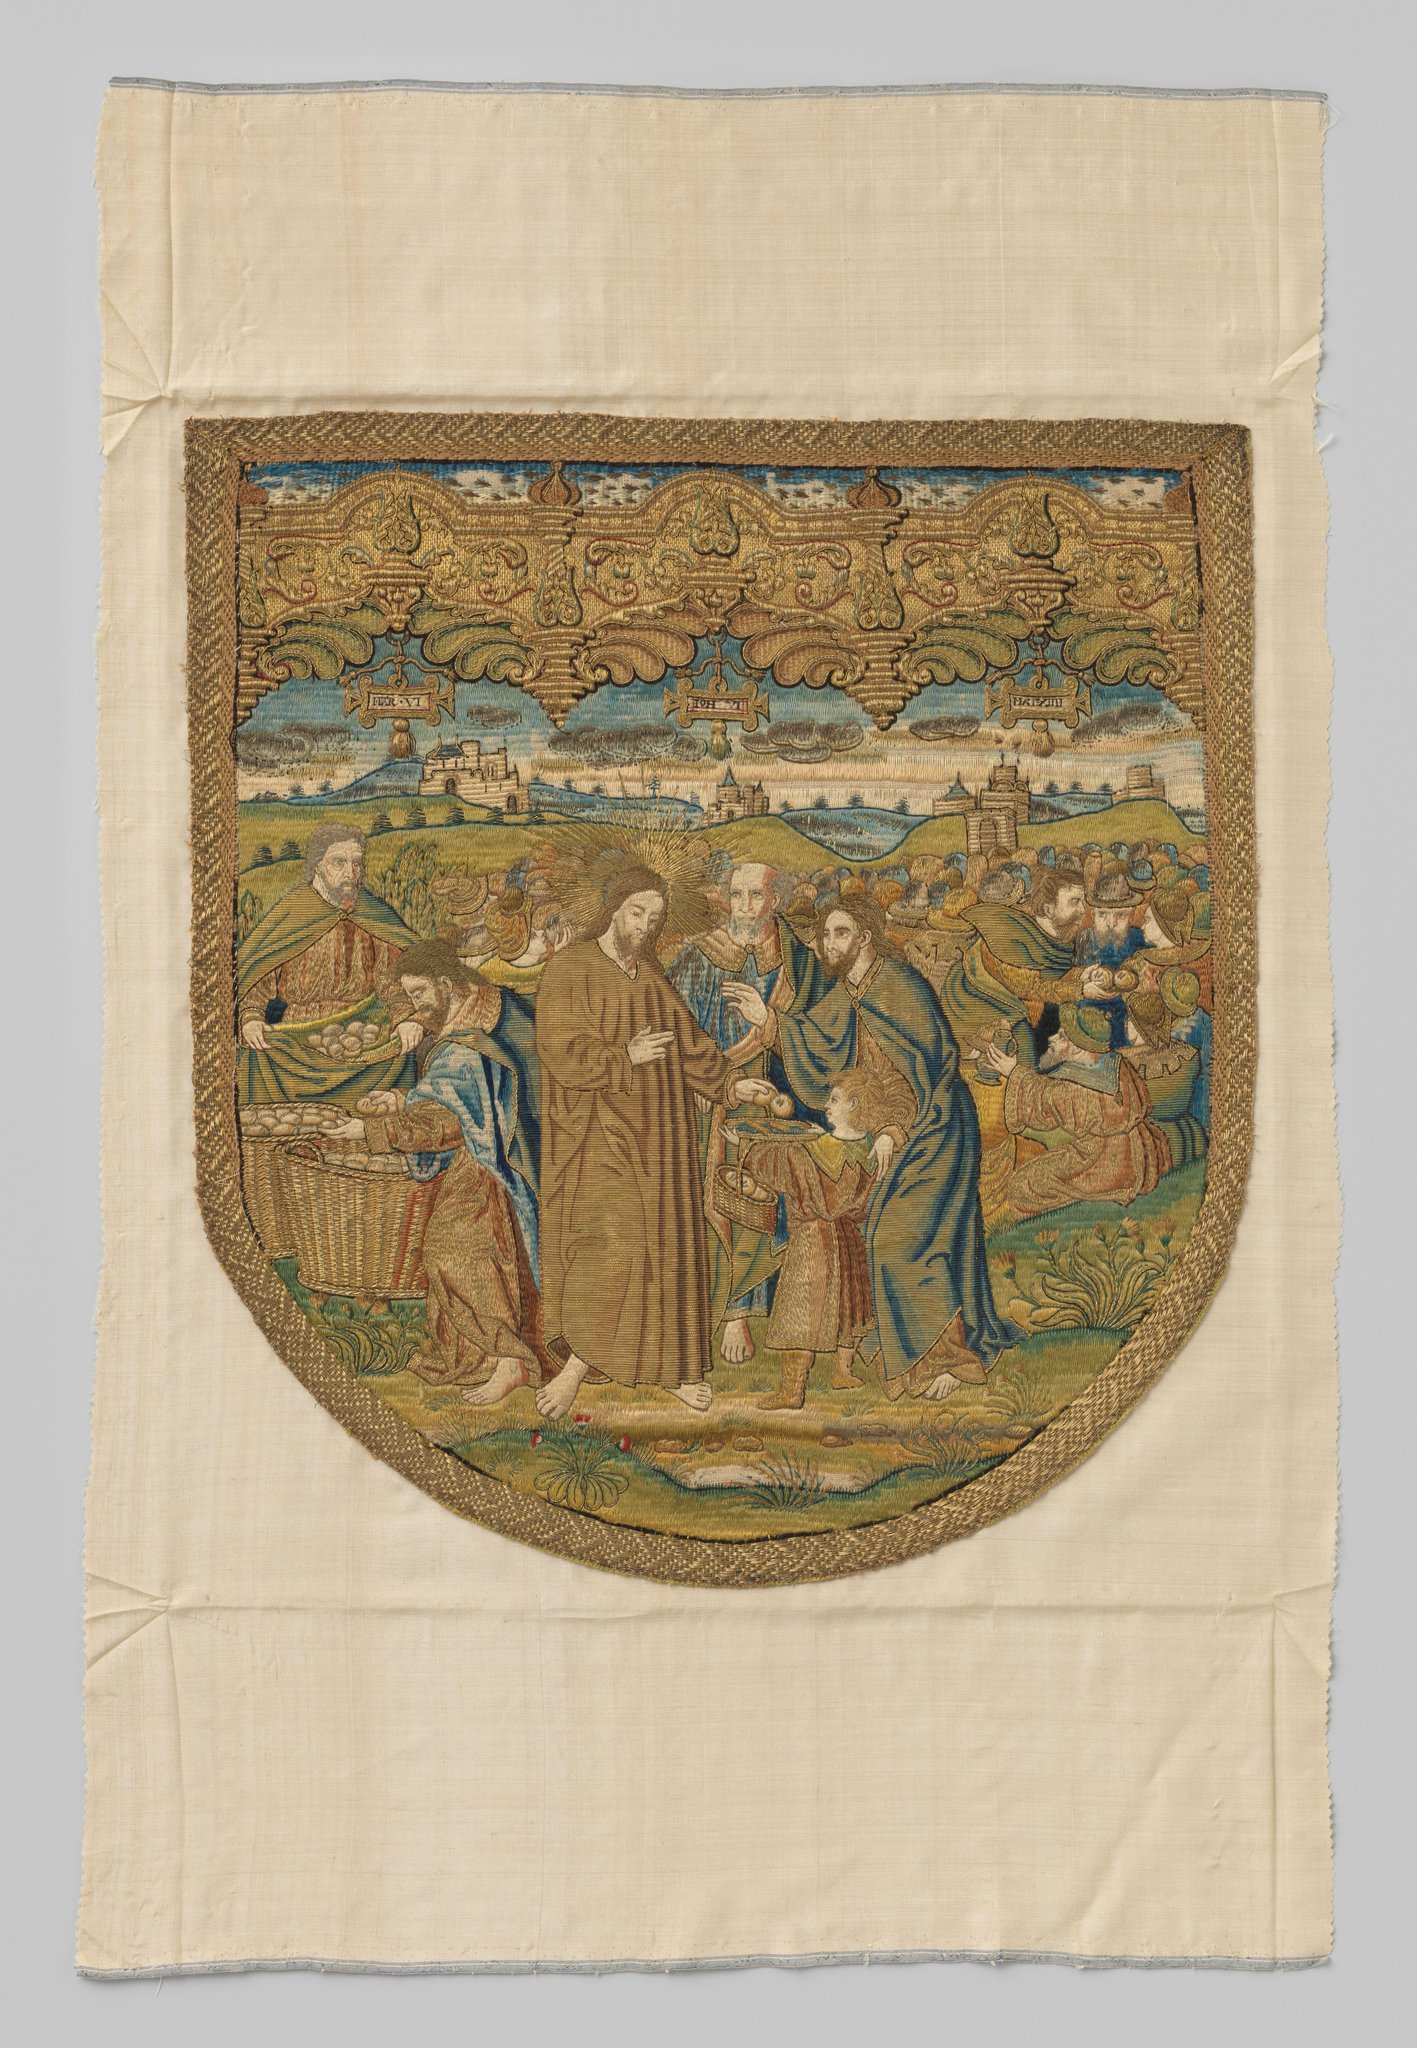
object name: cope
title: Rugschild van een koorkap, met borduurwerk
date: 1530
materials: gold thread, velvet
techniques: embroidered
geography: southern netherlands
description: Rugschild van een koorkap, met borduurwerk en stiksel in gouddraad. In een heuvelachtig landschap met kastelen is de bergrede en de uitdeling der broden afgebeeld. Christus wordt omringd door zijn discipelen en het volk. Boven de afbeelding is een ornamentrand geborduurd met in drie bogen de namen MAR VI, JOH VI en MAT XIII.